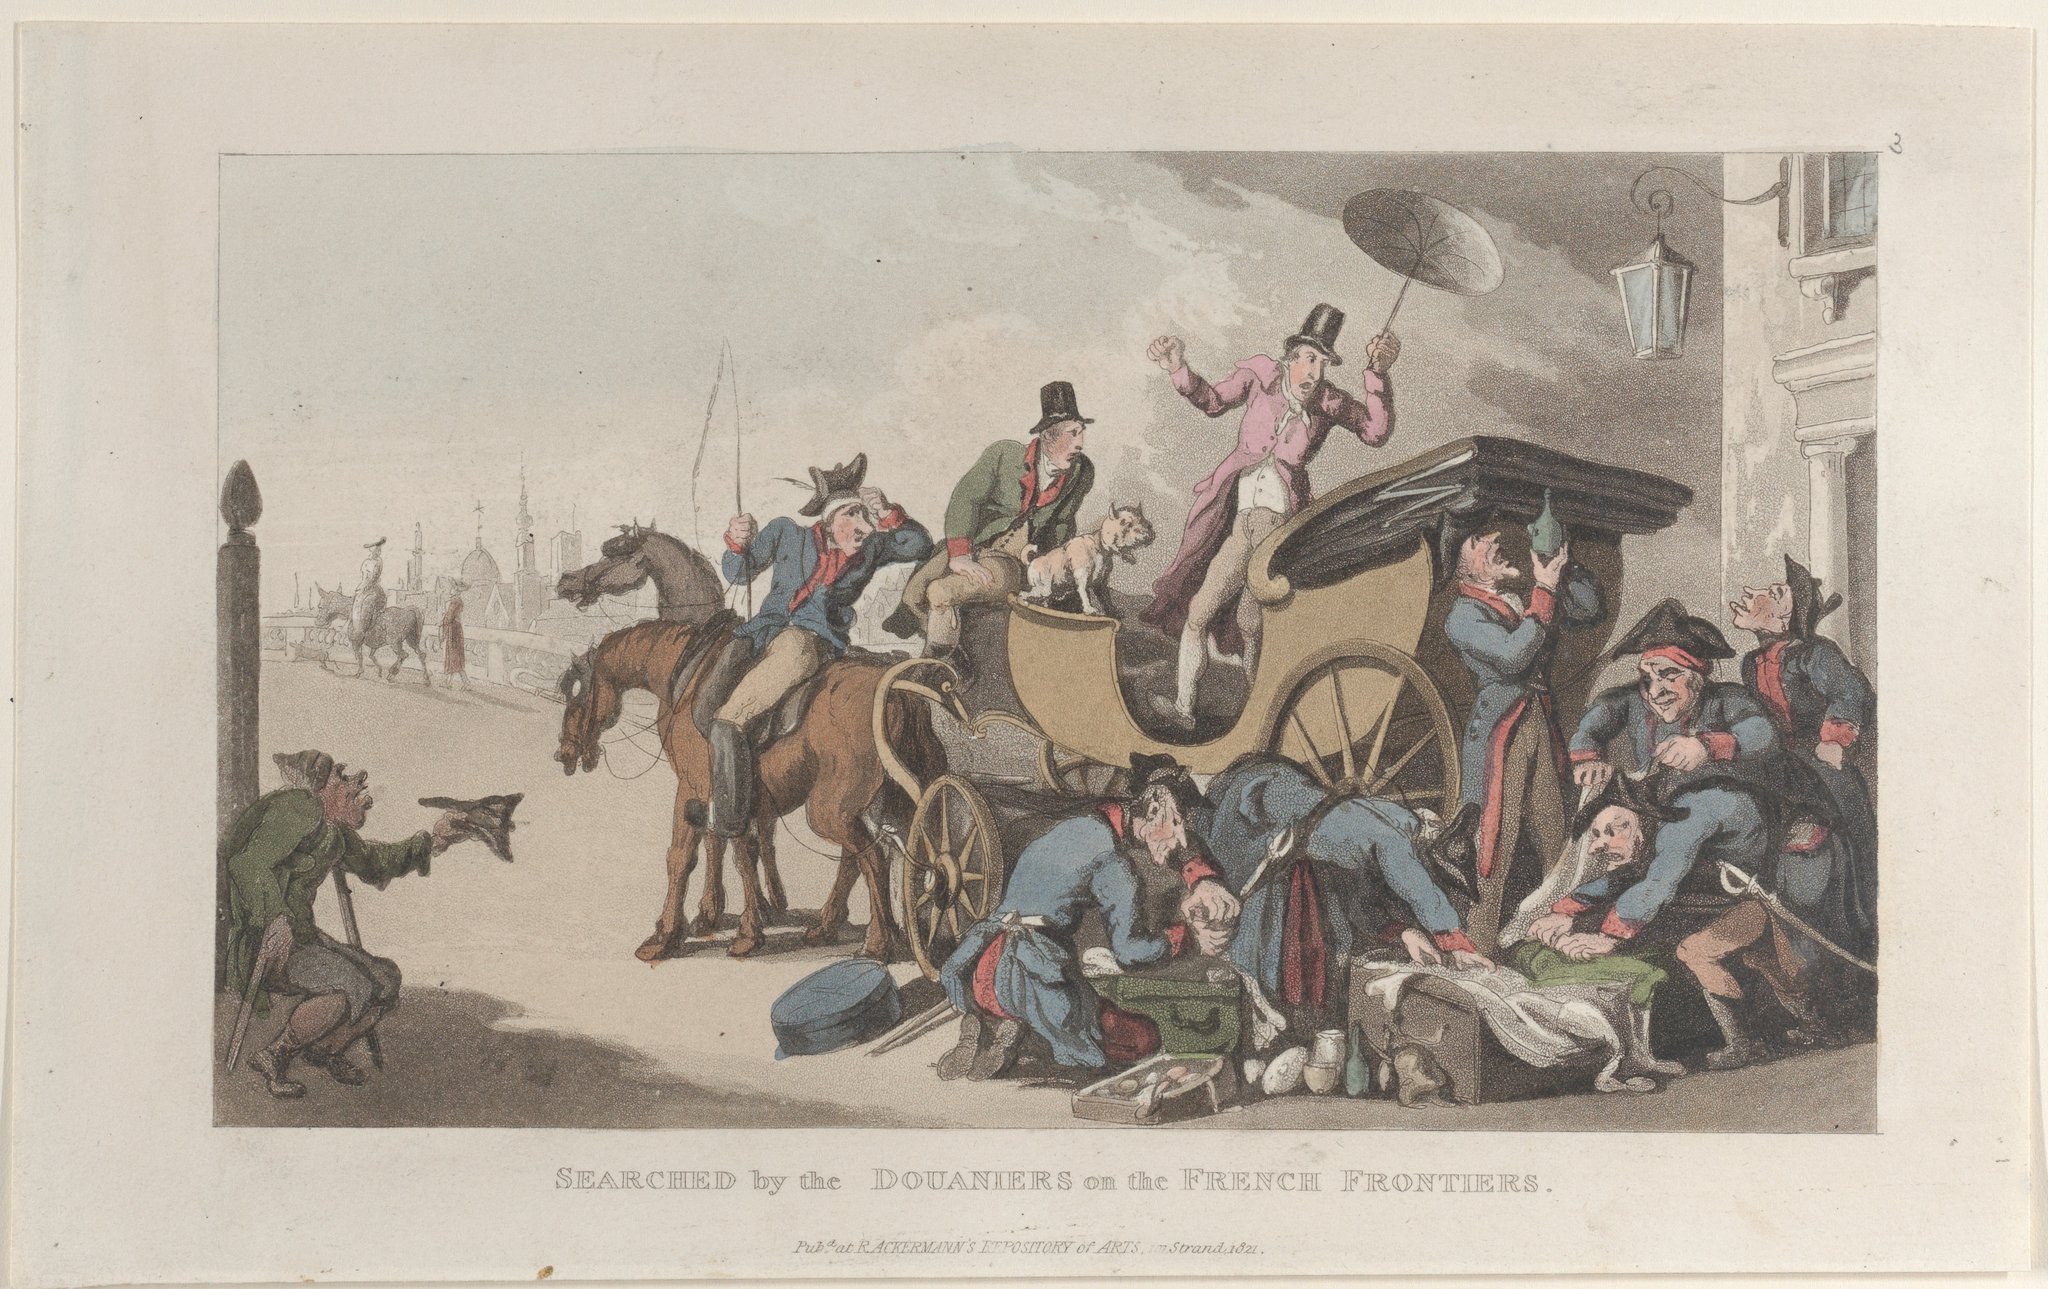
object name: print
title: Searched by the Douaniers on the French Frontiers, from "Journal of Sentimental Travels in the Southern Provinces of France, Shortly Before the Revolution"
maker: thomas rowlandson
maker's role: artist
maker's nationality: british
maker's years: 1757-1827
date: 1821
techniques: aquatint, etching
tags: men,dogs,horses,carriages